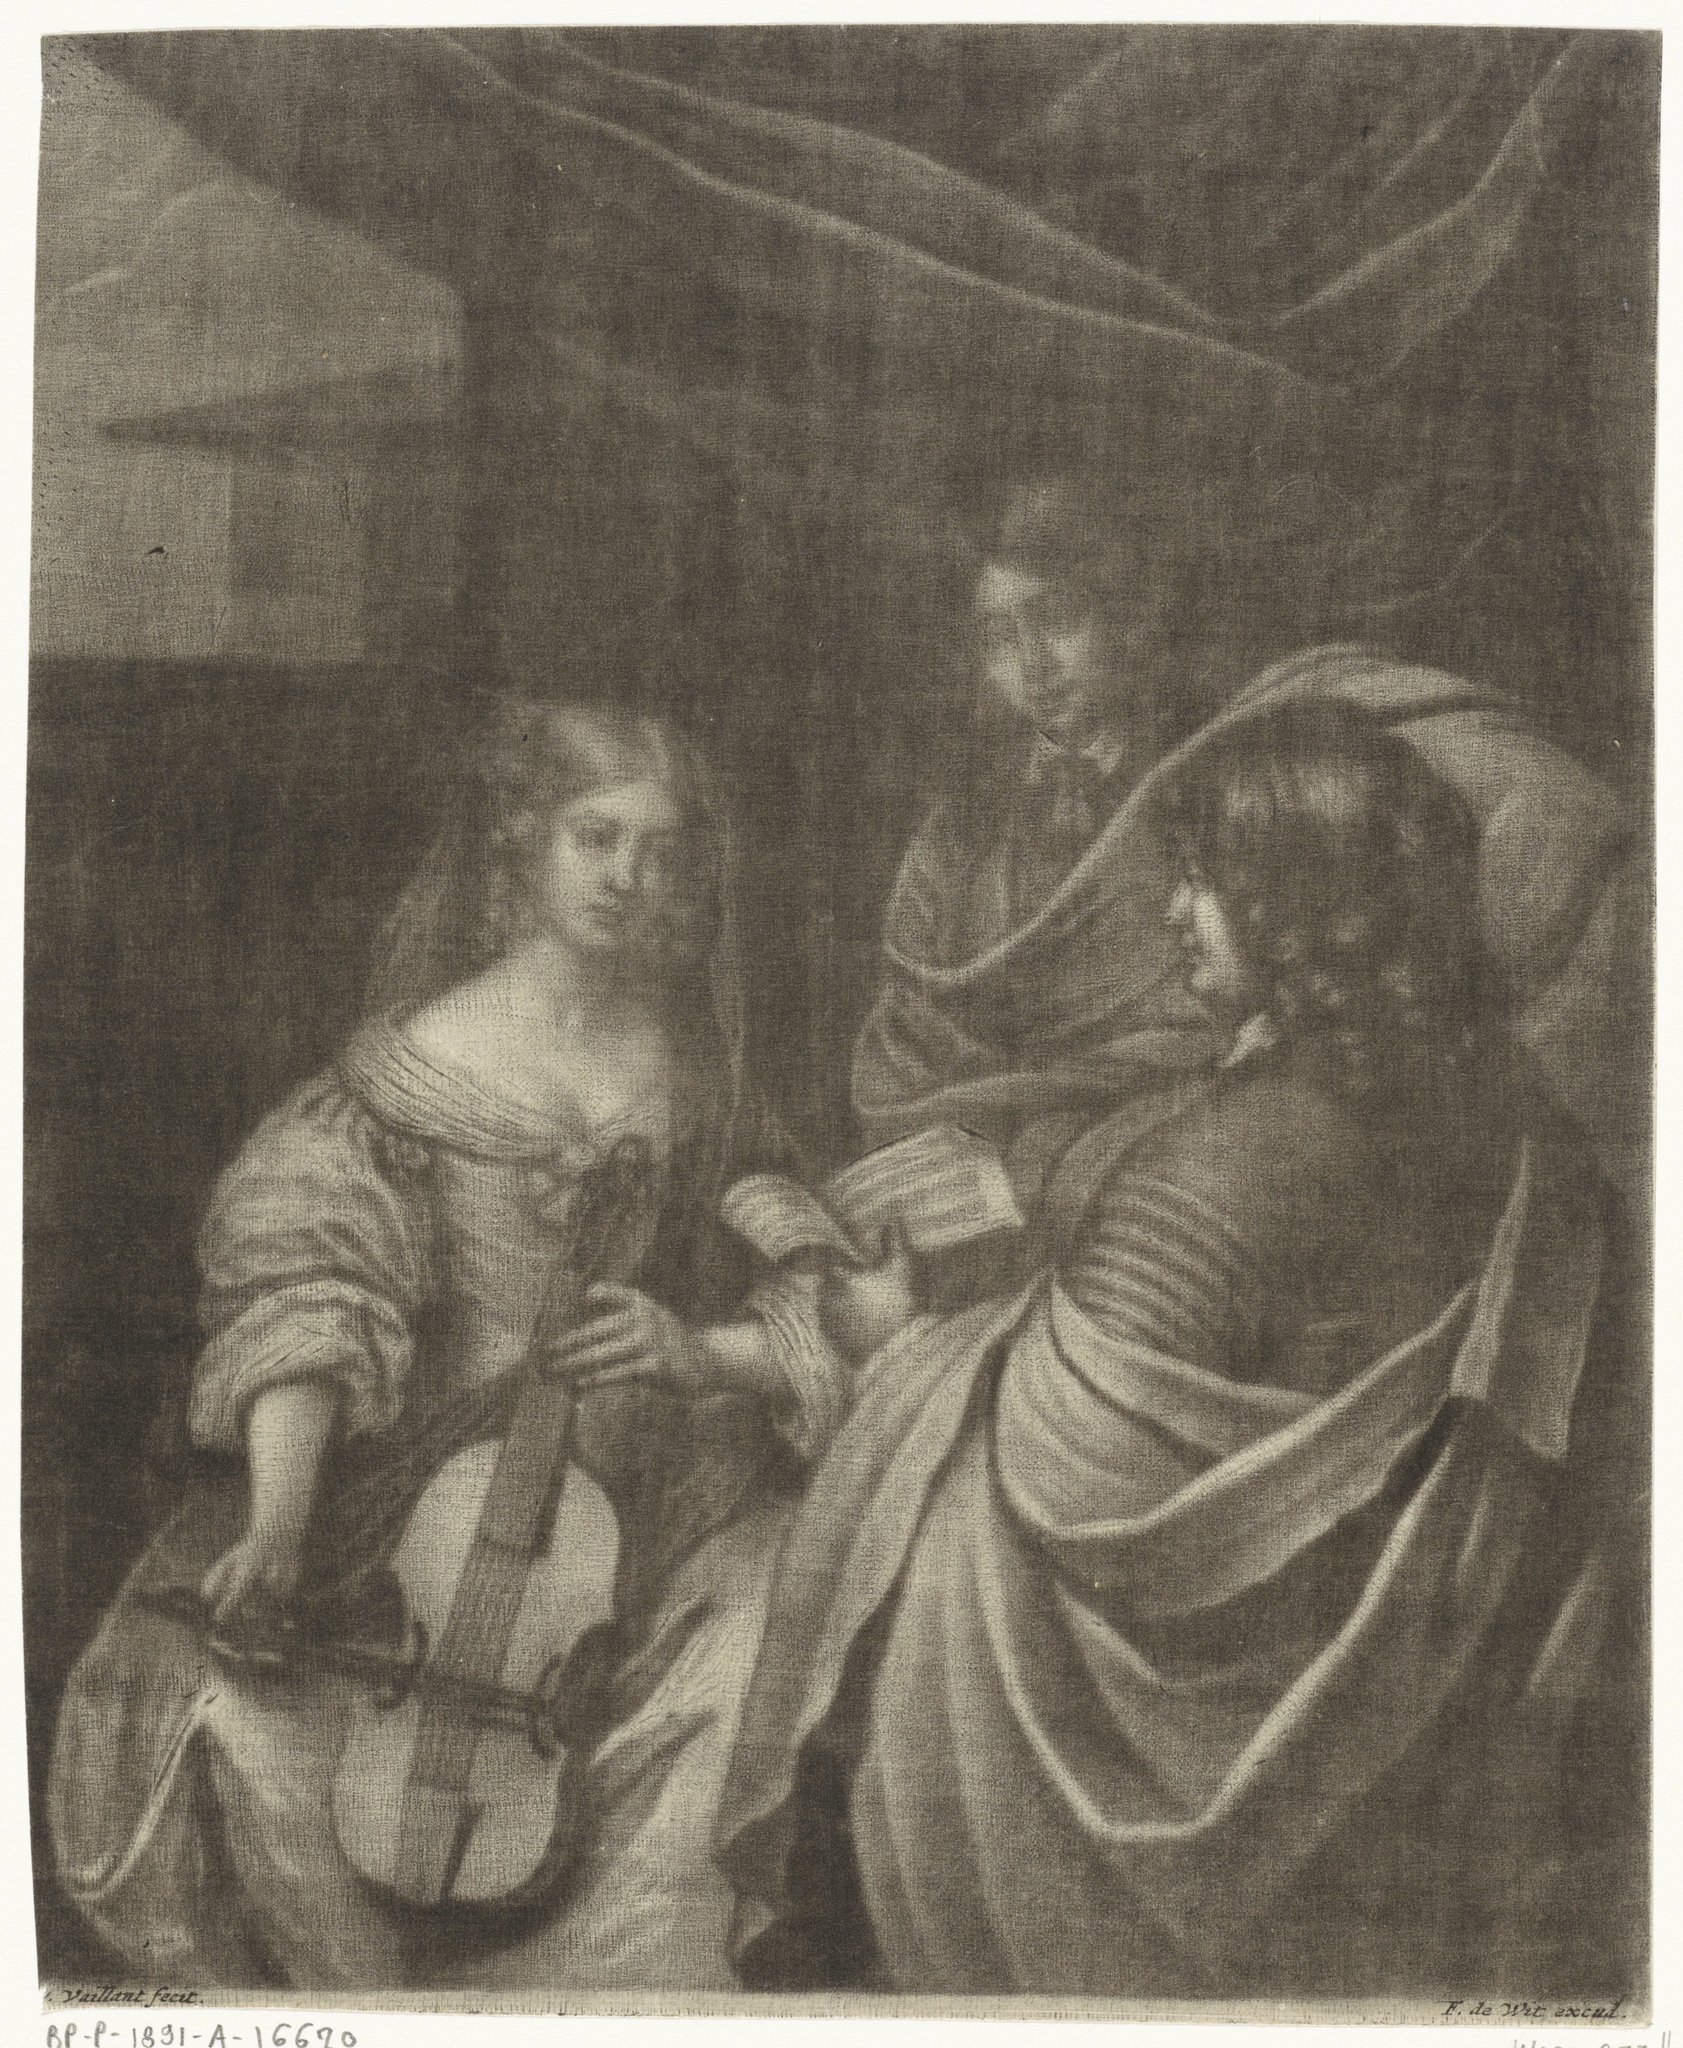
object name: print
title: Meisje met een violoncel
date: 1658-1706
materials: paper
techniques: mezzotint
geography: amsterdam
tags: viola, violoncello; double bass, printed edition of musical score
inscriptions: collector's mark: Lugt 240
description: Een meisje speelt violoncel voor twee mannen, waarvan er één een muziekboekje in de hand heeft.